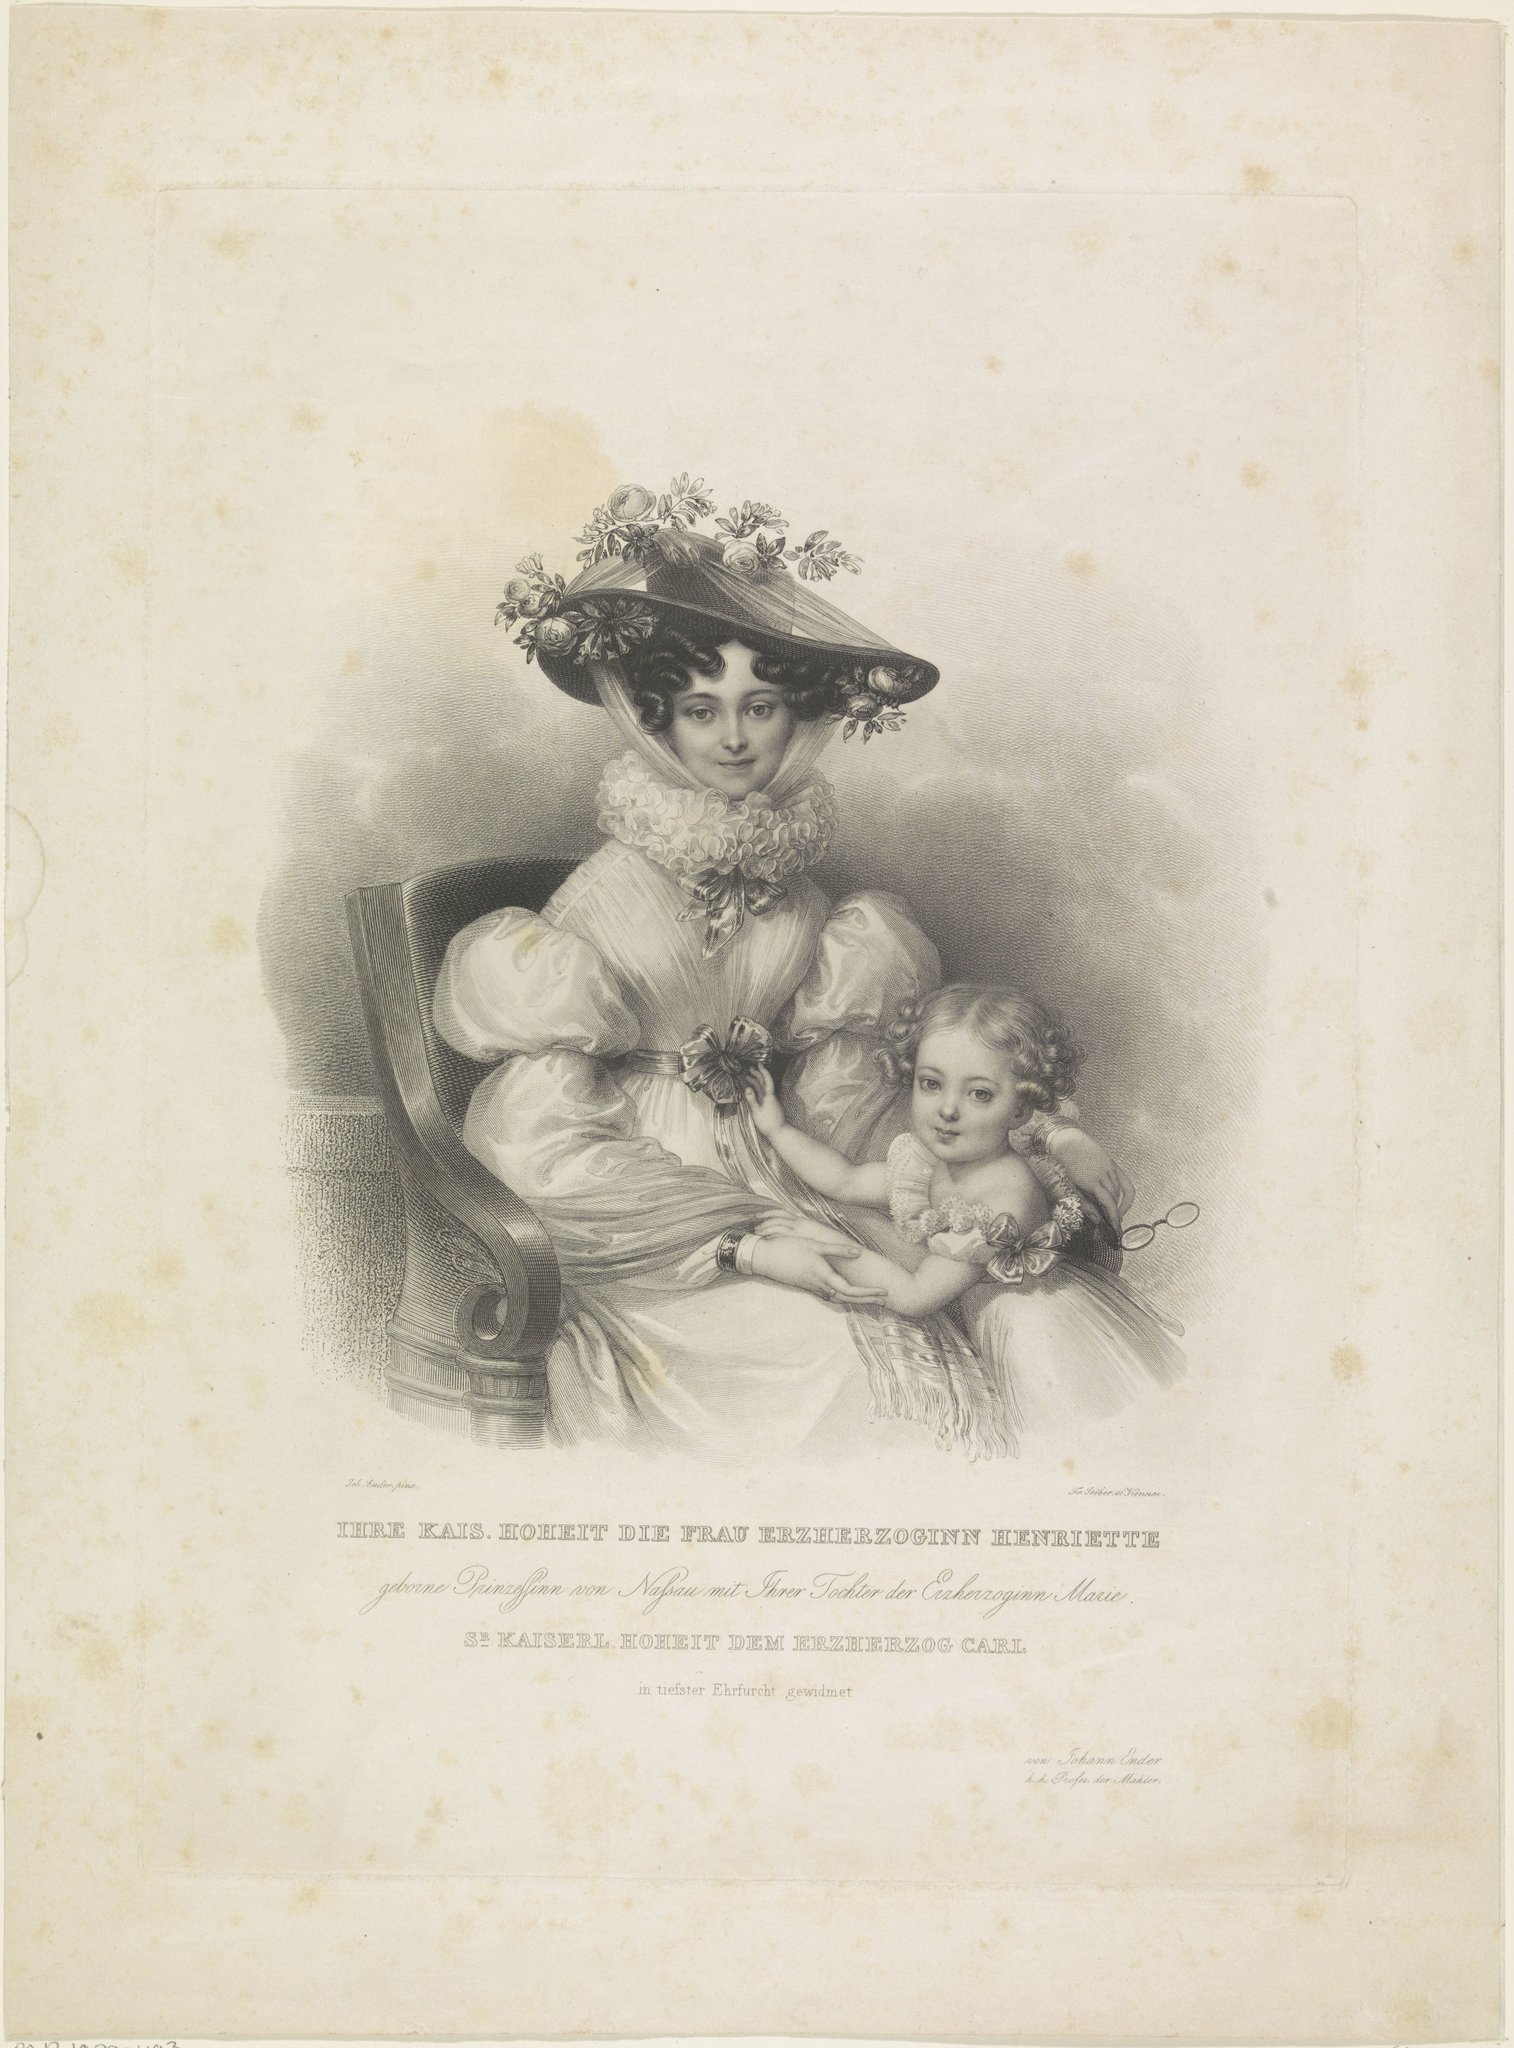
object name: print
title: Portret van Henriëtte van Nassau-Weilburg en Maria Caroline van Oostenrijk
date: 1827-1834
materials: paper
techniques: engraving, etching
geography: vienna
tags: vienna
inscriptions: collector's mark: Lugt 2228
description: Portret van Henriëtte en Maria Caroline. In de ondermarge hun namen en titels.